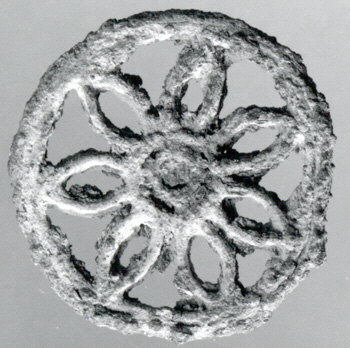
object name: stamp seal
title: Compartmented stamp seal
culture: bactria-margiana archaeological complex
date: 2333-1668 BCE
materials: copper alloy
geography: bactria-margiana